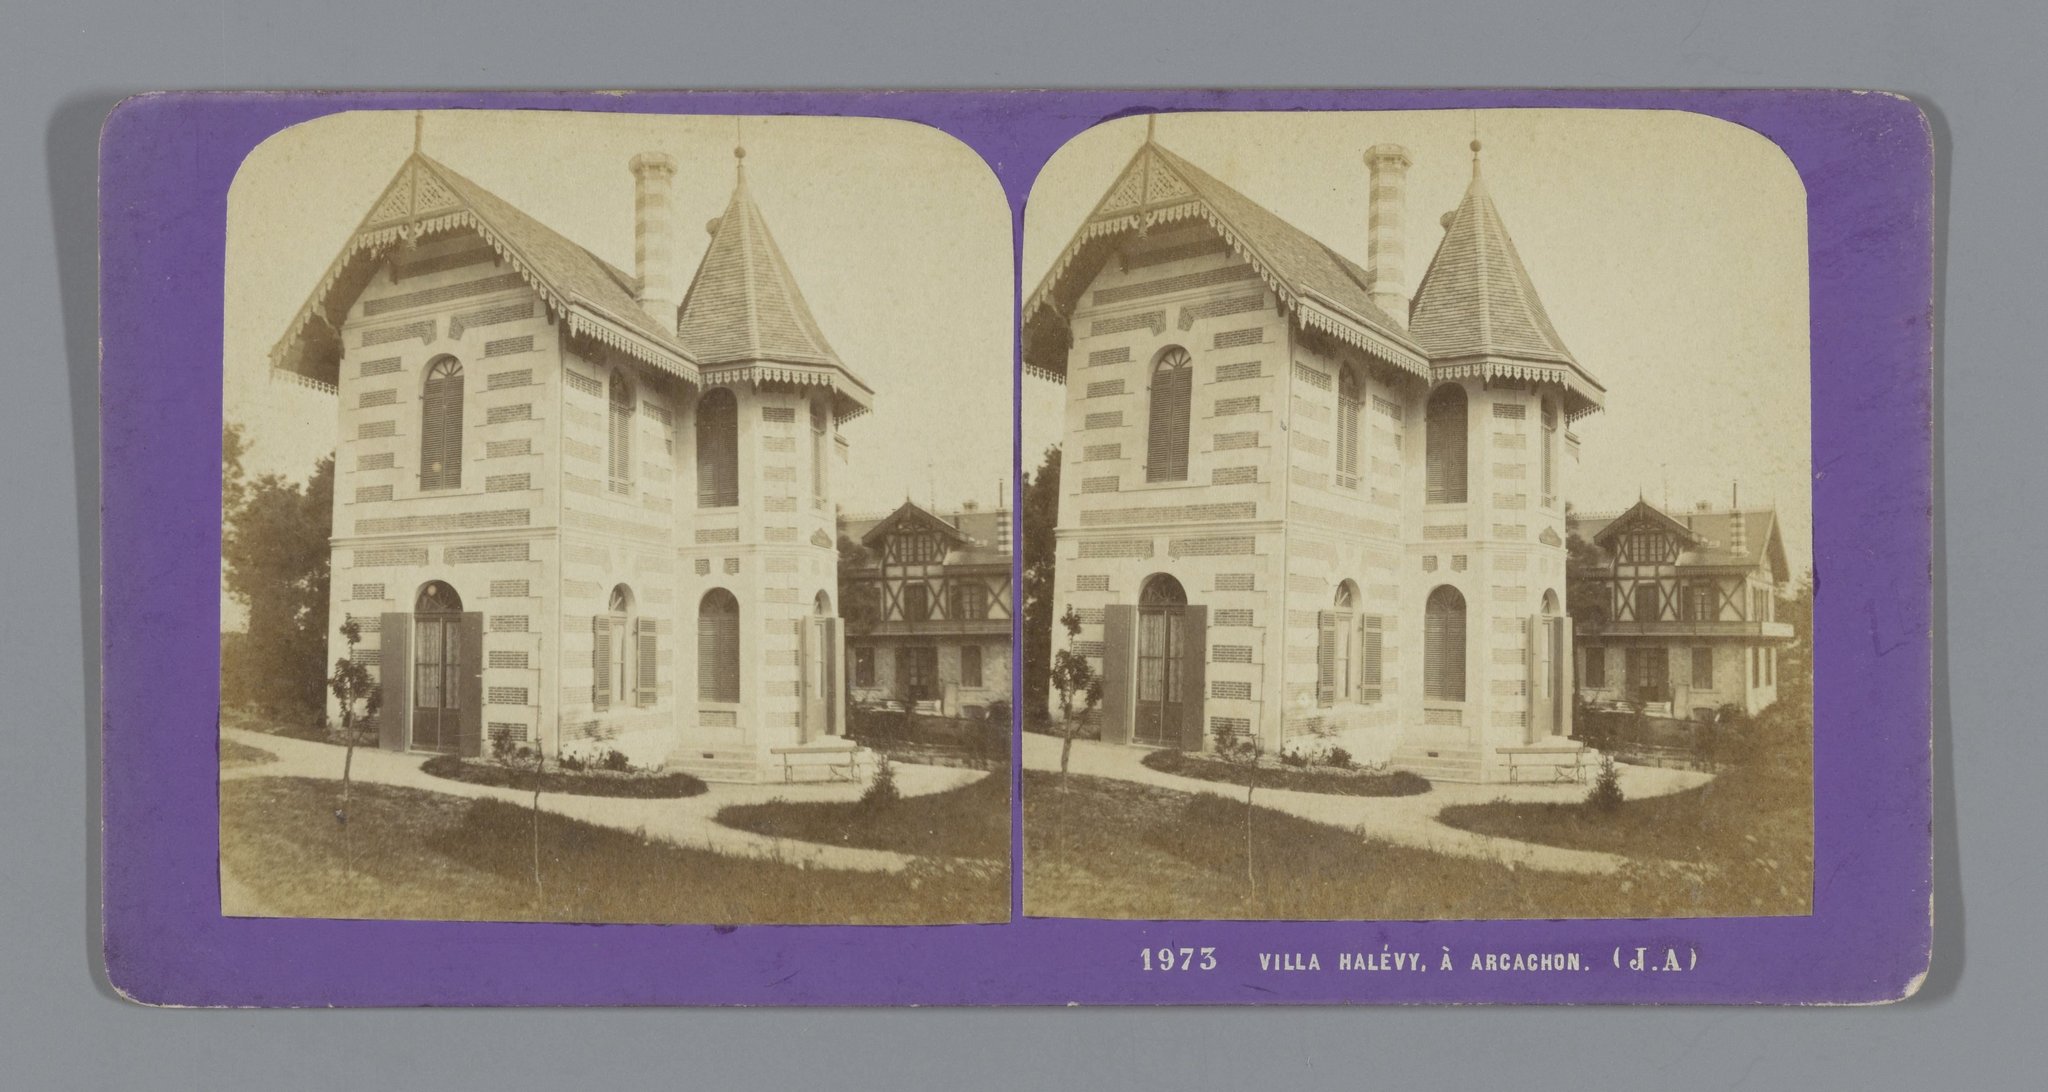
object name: stereograph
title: Exterieur van Villa Halévy te Arcachon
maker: jean andrieu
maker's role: fotograaf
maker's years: 1816-1872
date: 1862-1876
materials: cardboard, photographic support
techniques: albumen print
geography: arcachon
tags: rural housing, e.g. country-house, villa, cottage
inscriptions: number: ‘1973’